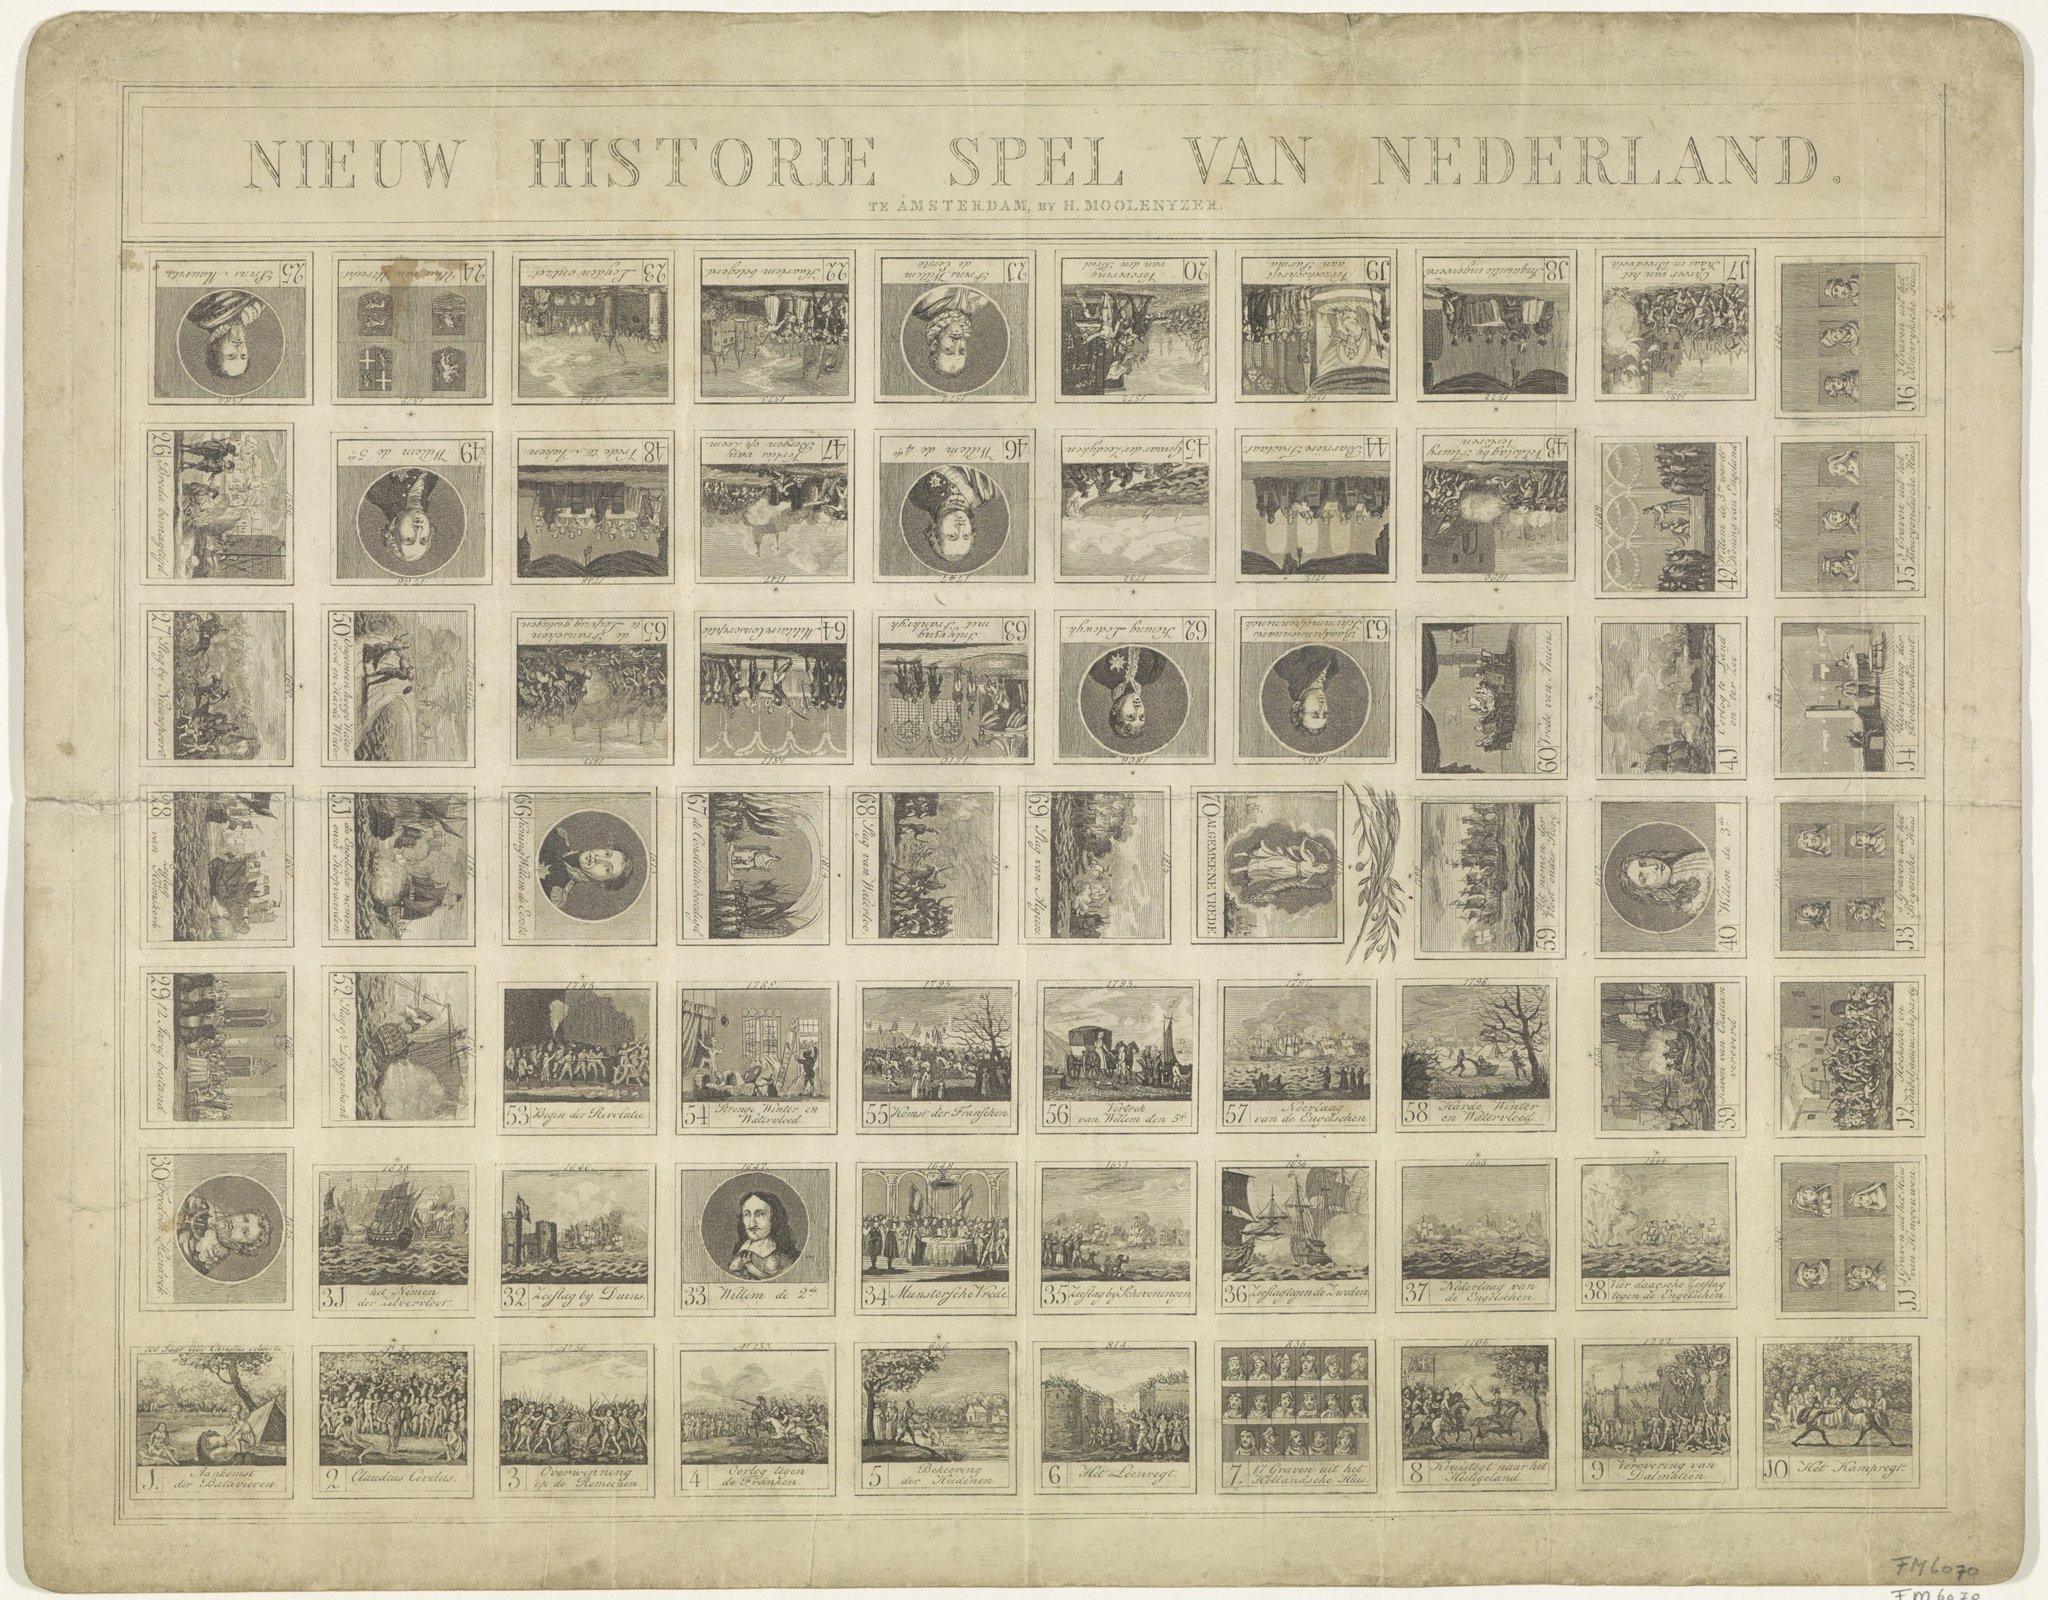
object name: print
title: Bordspel over de geschiedenis van Nederland, 1815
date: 1815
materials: cardboard, paper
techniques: aquatint, engraving, etching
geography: amsterdam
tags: goose-game, historical events and situations; historical persons, netherlands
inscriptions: collector's mark: Lugt 2228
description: Bordspel over de geschiedenis van Nederland met vakken genummerd 1-70. Beginnend met de aankomst van de Batavieren in Nederland (100 jaar v. Chr.) en eindigend met de Vrede van Parijs (1815).